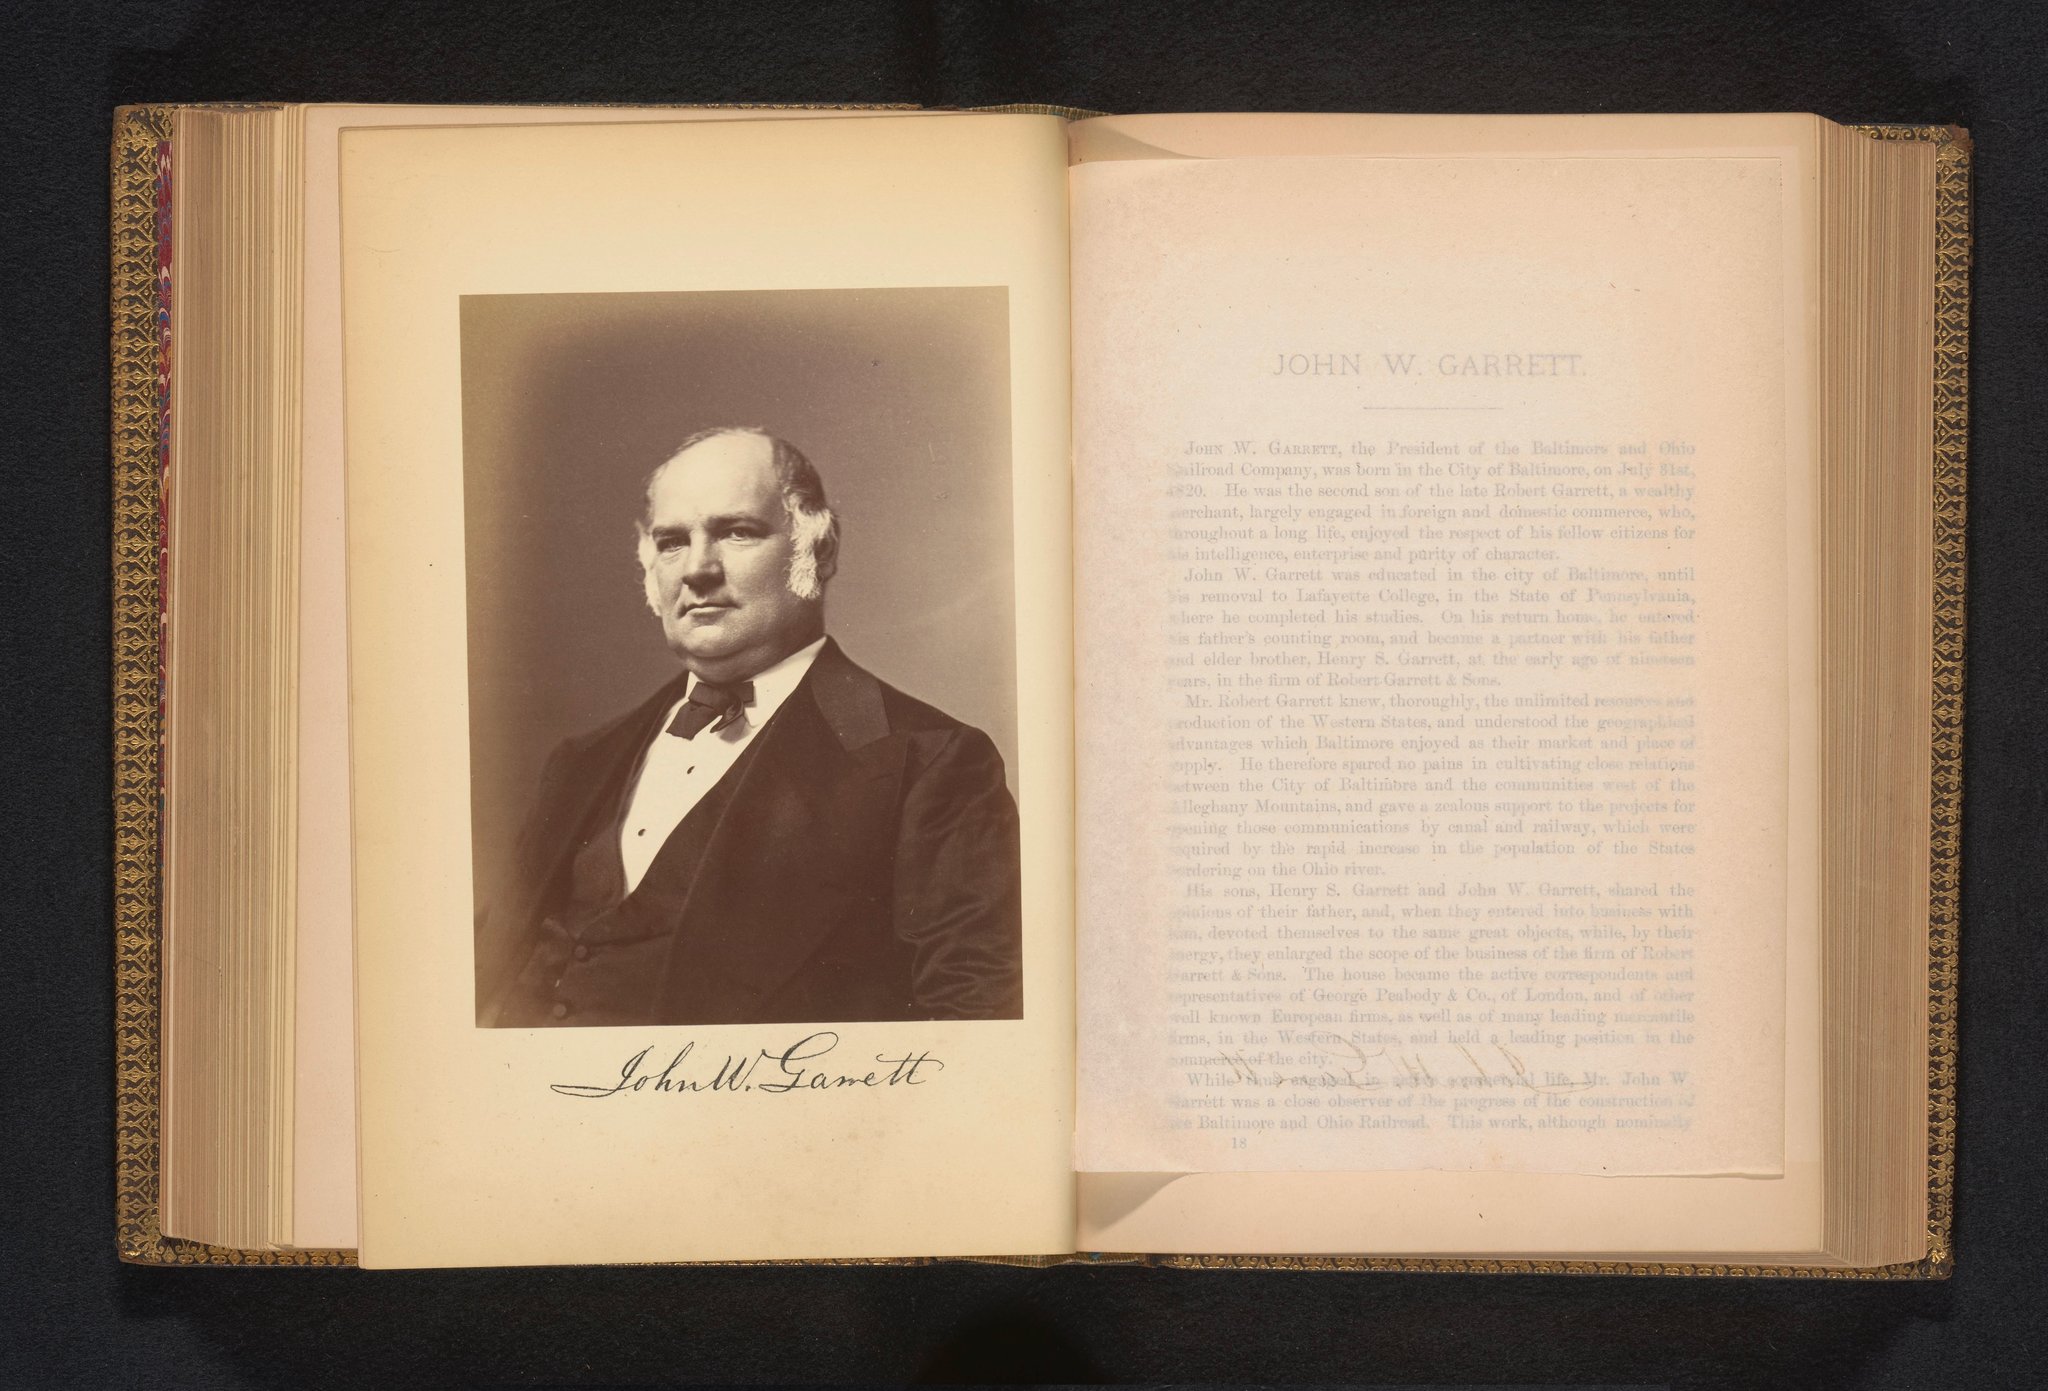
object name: photograph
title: Portret van John W. Garrett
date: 1866-1871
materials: photographic support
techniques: albumen print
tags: historical persons